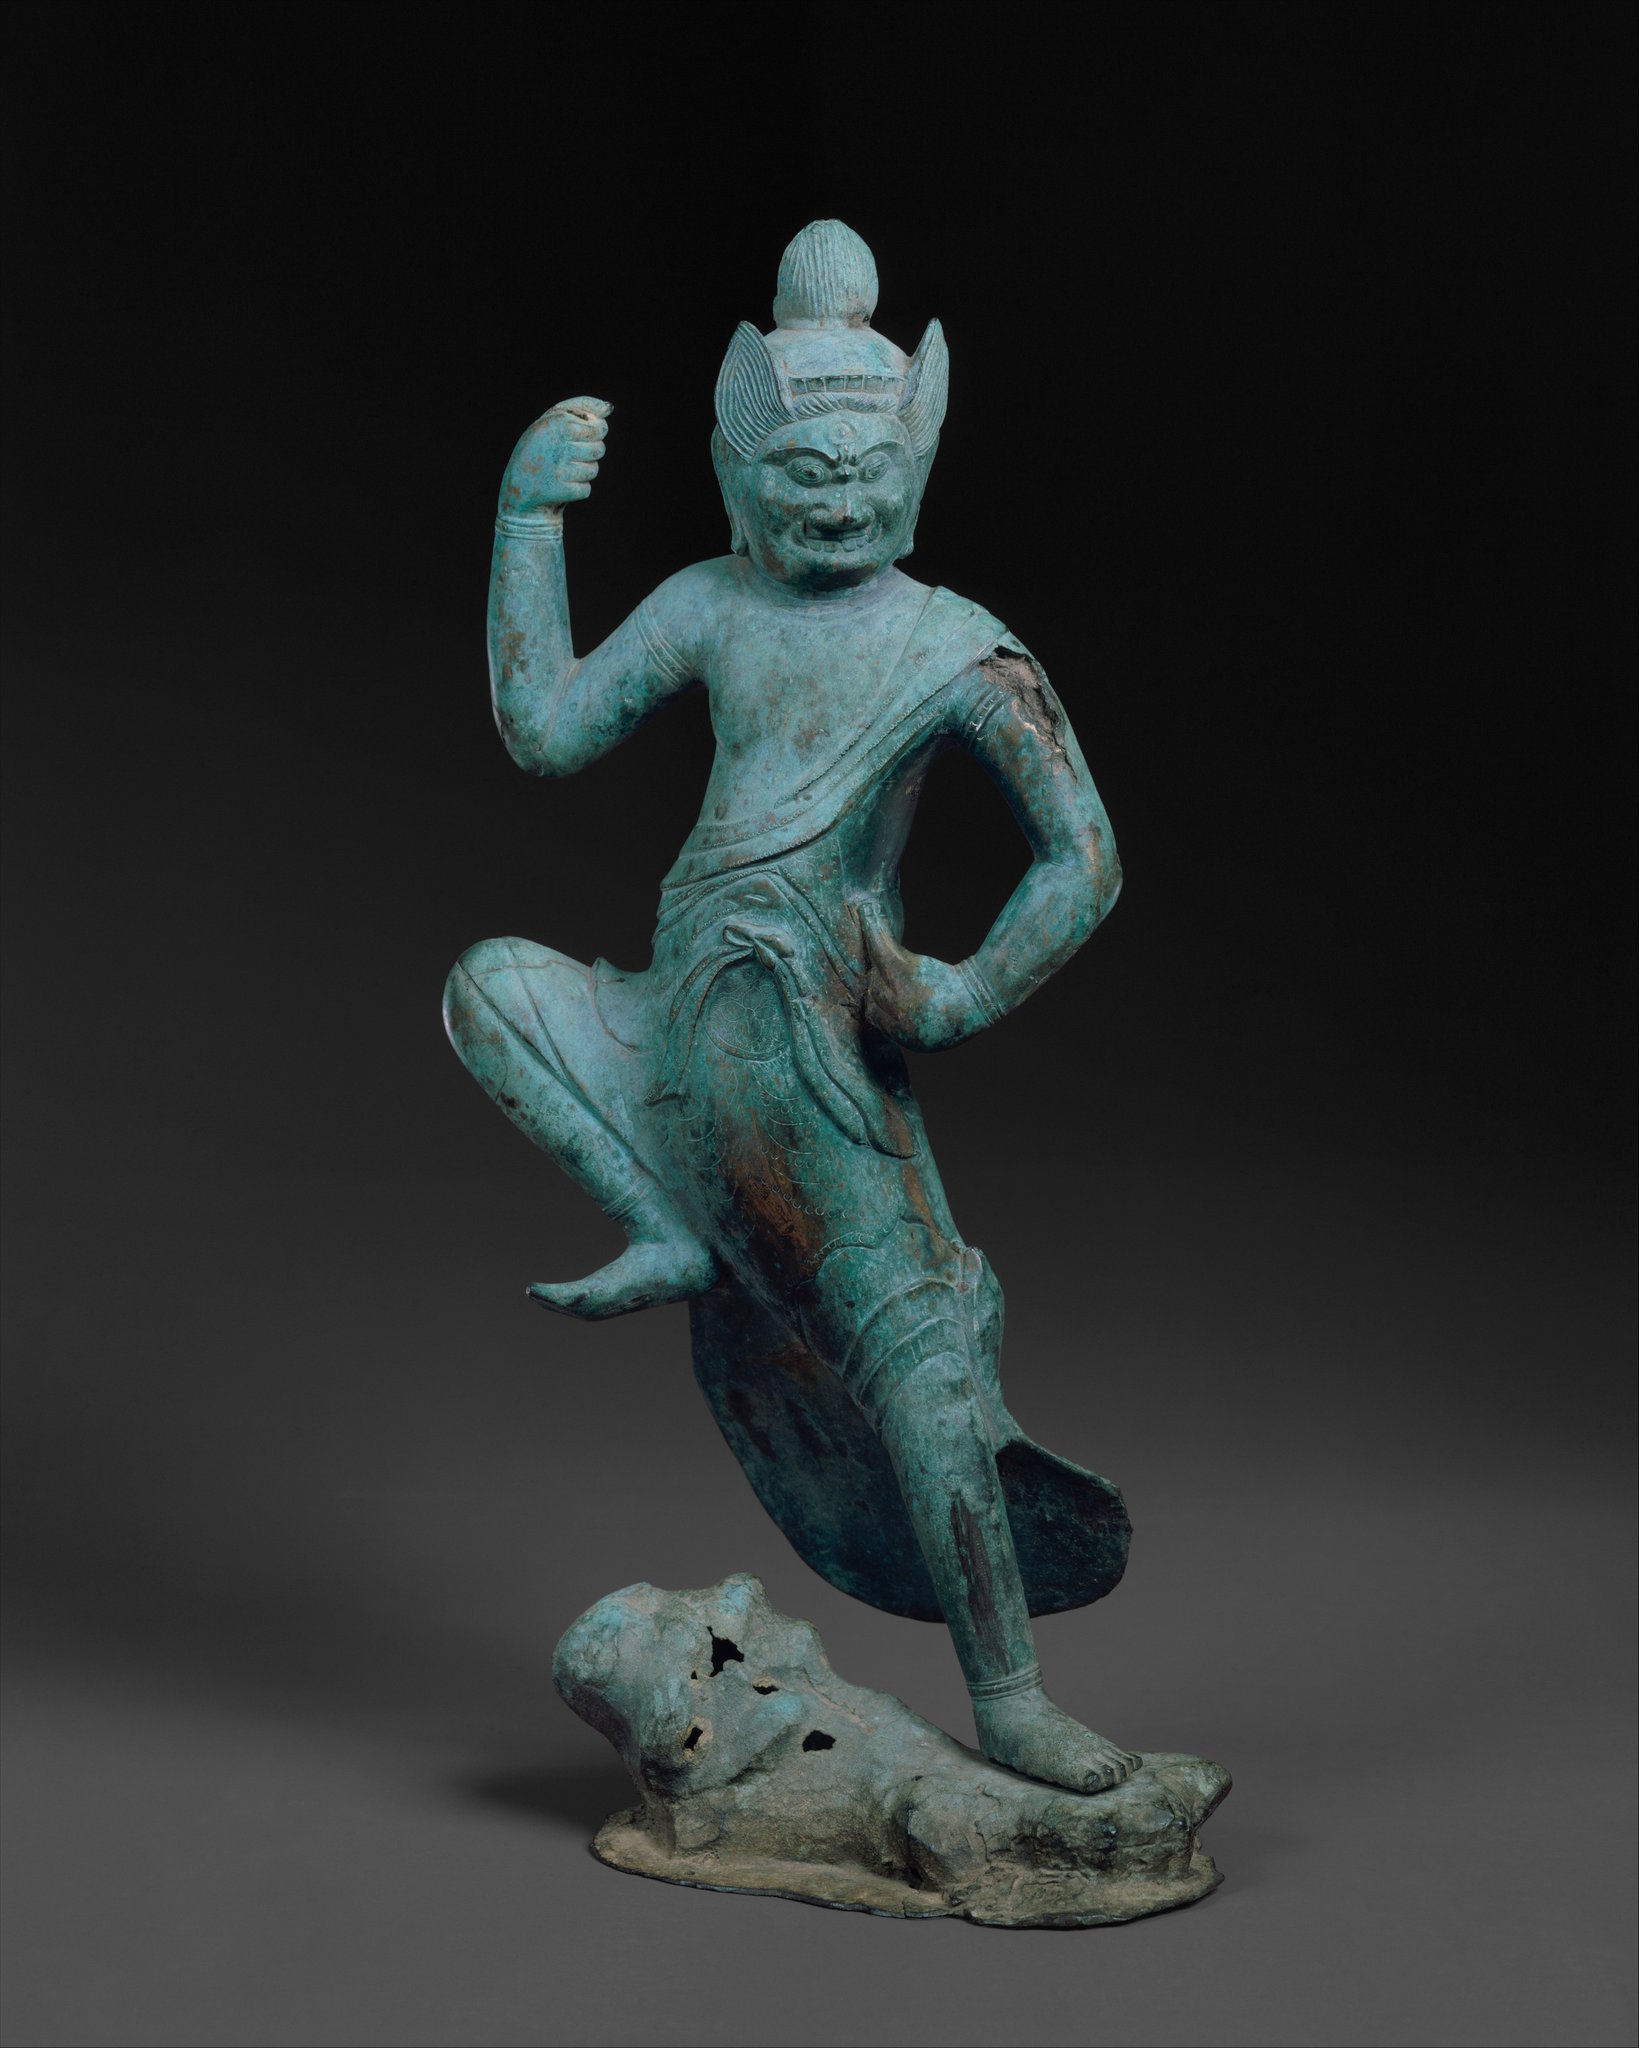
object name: figure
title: Zaō Gongen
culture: japanese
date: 1001-1100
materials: gilt bronze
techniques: incising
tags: deities